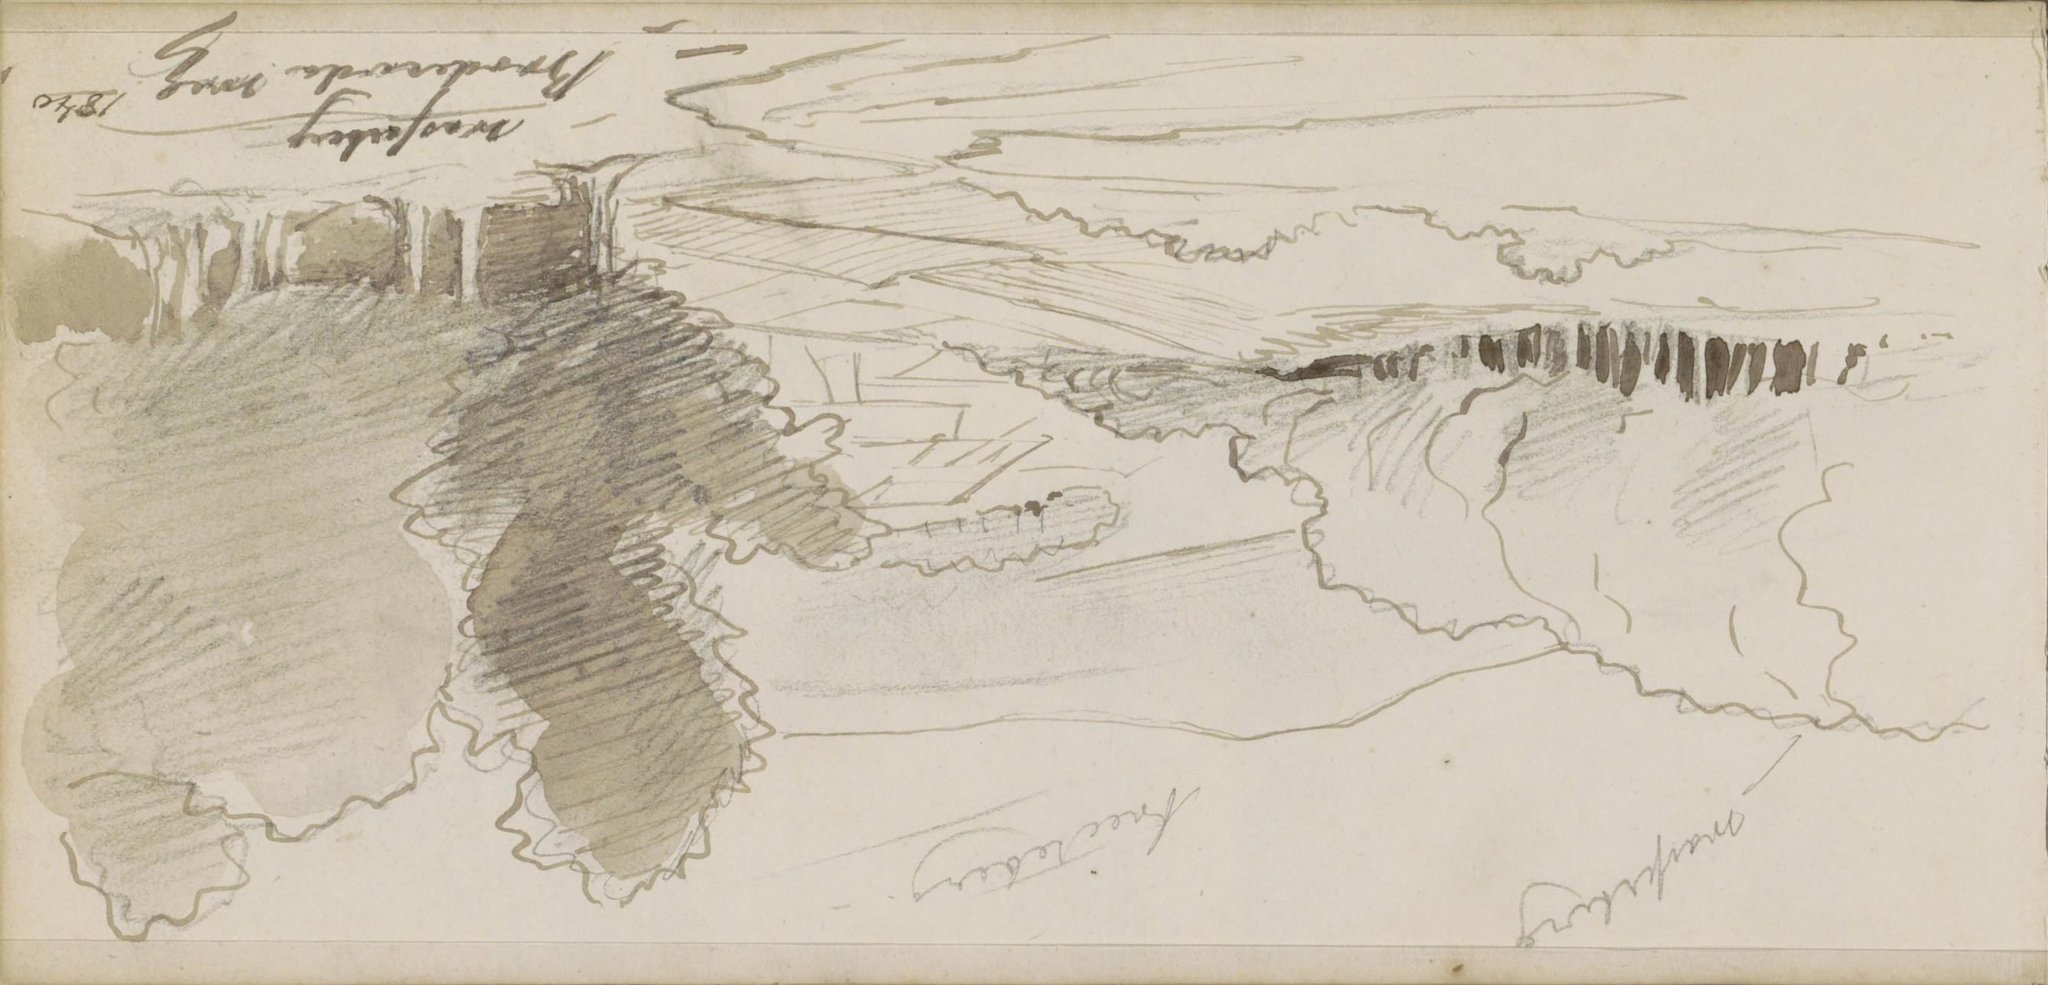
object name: sketchbook leaf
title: Wassenberg bij Brotterode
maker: johannes tavenraat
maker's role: draughtsman, painter, print maker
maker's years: 1809-1881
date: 1807-1840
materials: ink, paper, pencil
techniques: brush, pen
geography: schwarzburg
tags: trees, mountains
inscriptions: date and inscription: ‘wassenberg/ bre[...]berg/ Wassenberg/ Brotteroda July 1840’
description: Blad 61 verso uit een schetsboek met 63 bladen.